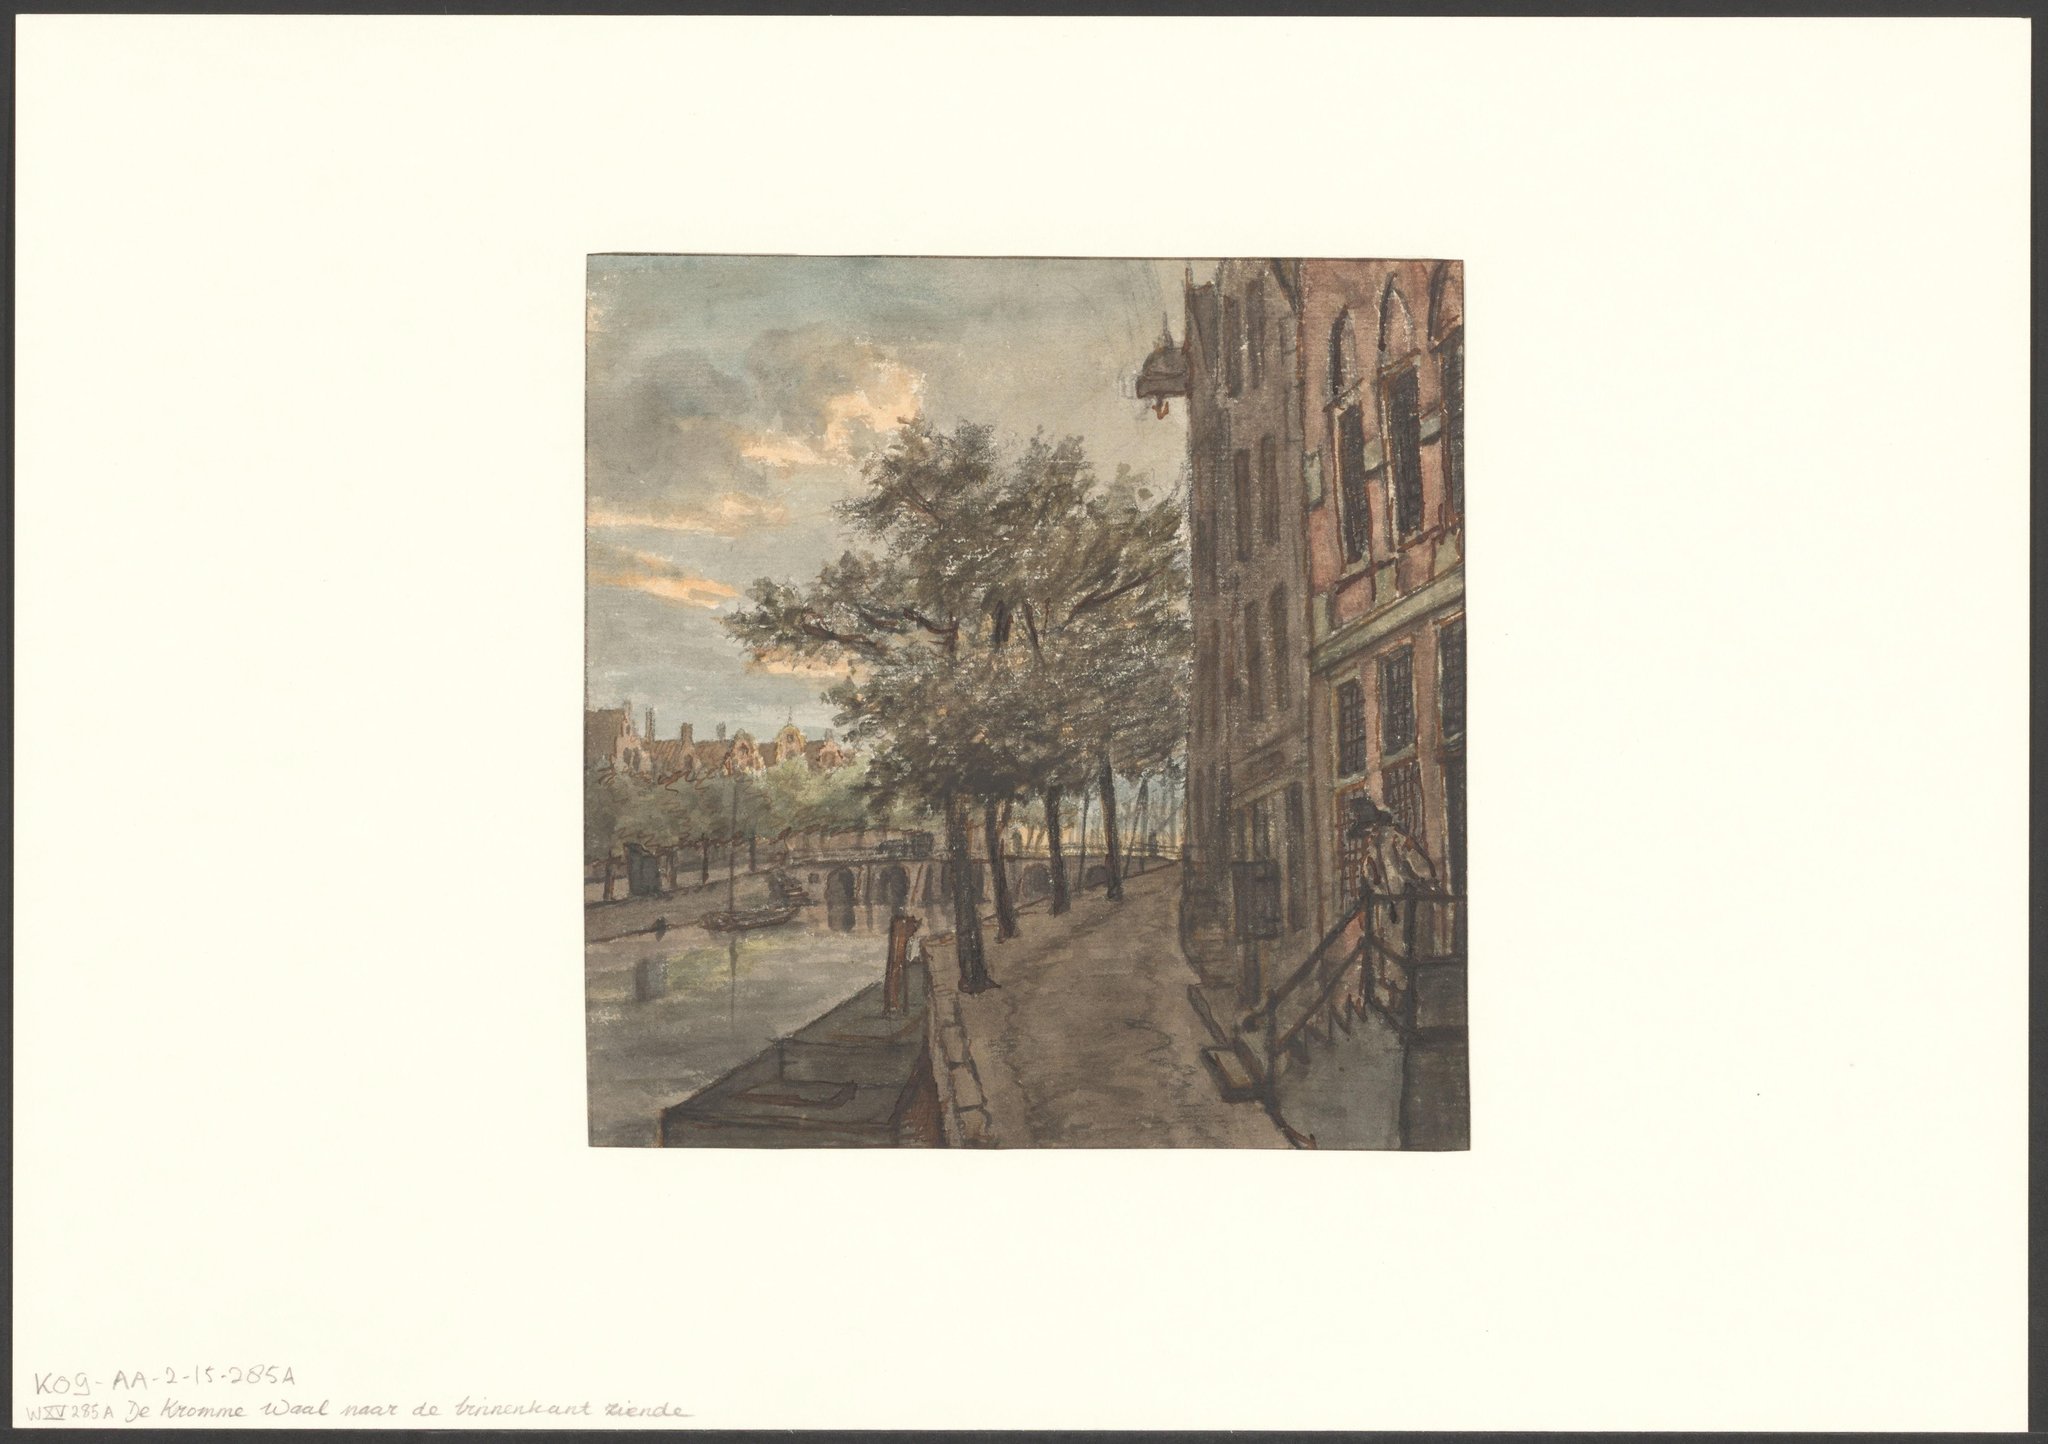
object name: drawing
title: Gezicht op de Kromme Waal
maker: gerrit lamberts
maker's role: bookseller, draughtsman, print maker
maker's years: 1776-1850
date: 1786-1850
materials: chalk, ink, paper, pencil, watercolor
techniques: brush, pen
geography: amsterdam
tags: city-view in general; 'veduta', canal, bridge in city across river, canal, etc.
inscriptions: inscription: ‘Kromme Waal / Na de Binnekandt Ziende’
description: Tekening binnen de Atlas Van Eck ingedeeld op wijknummer 15.